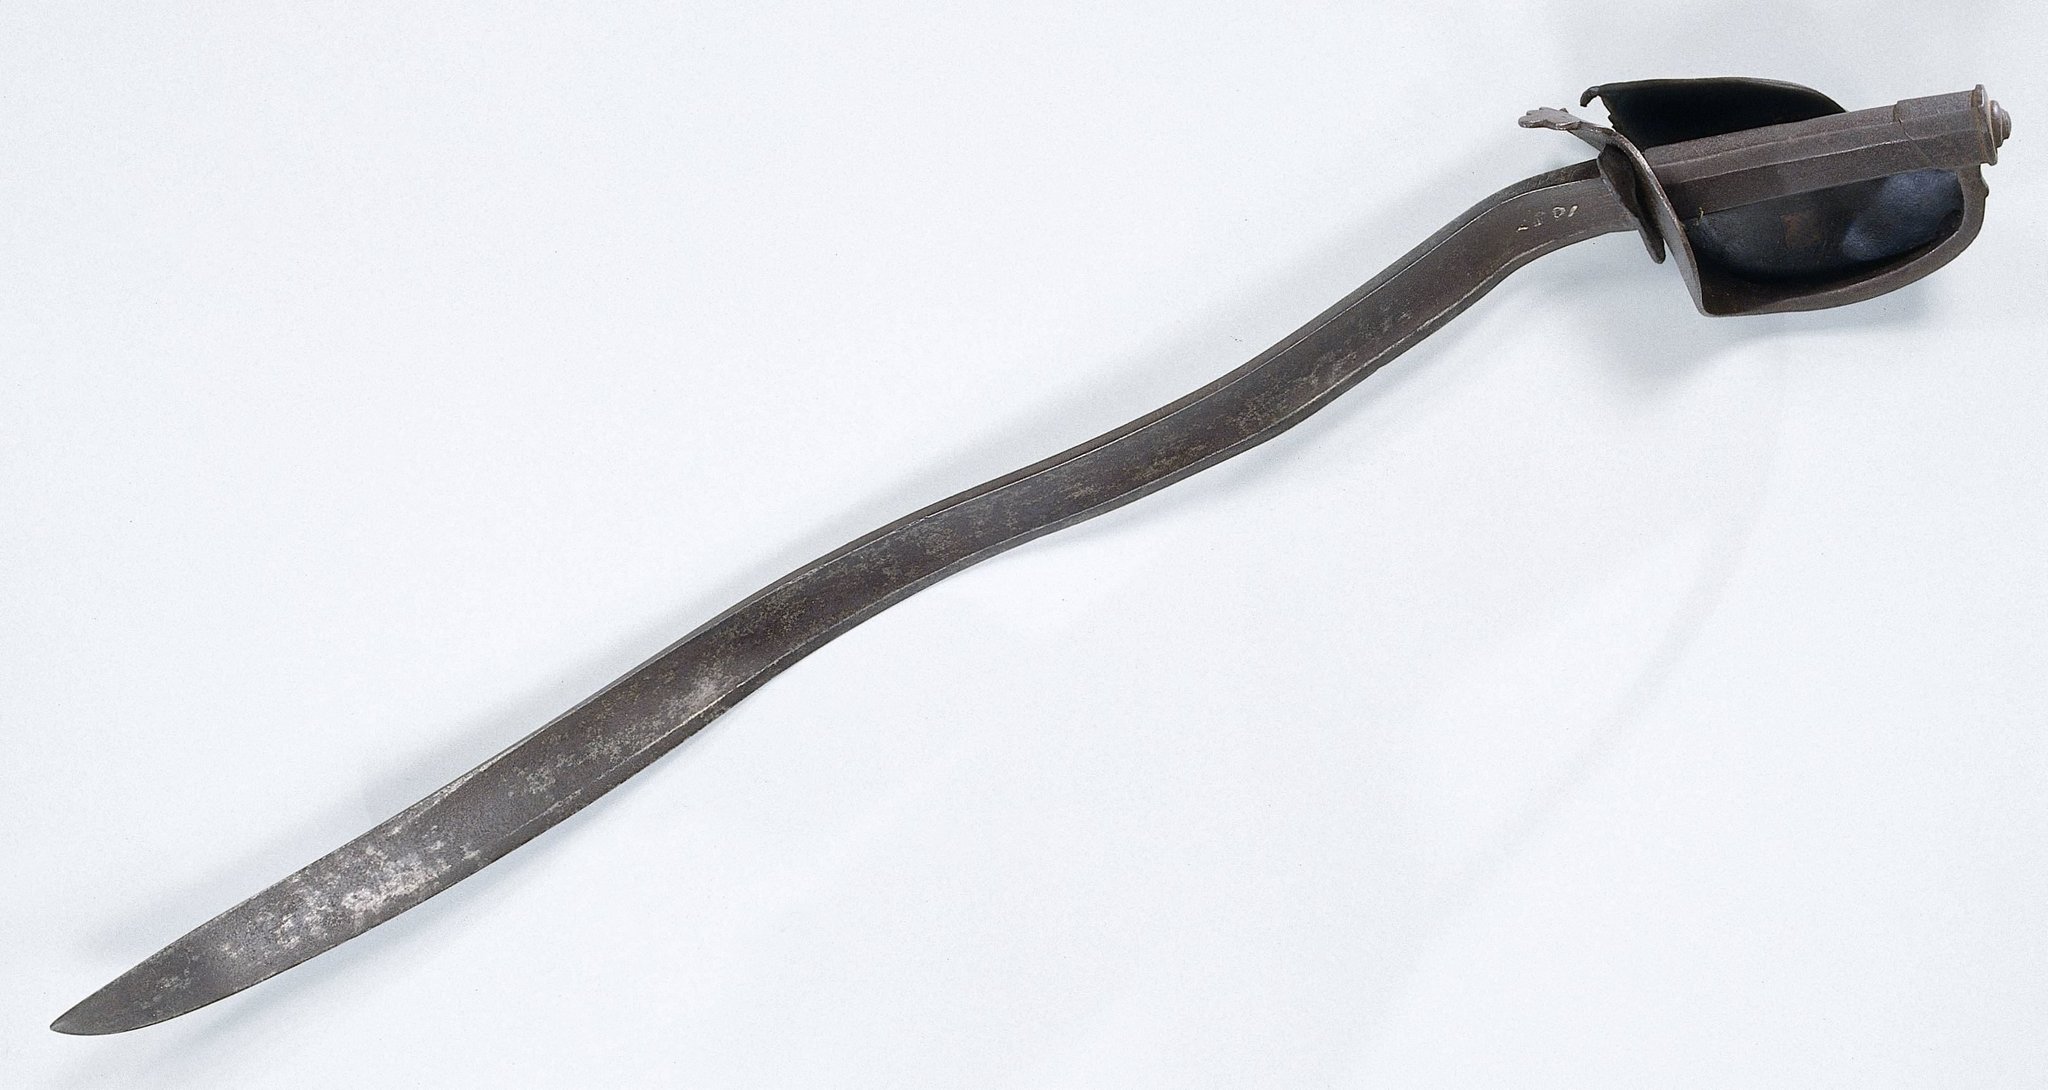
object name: sabre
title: Marinesabel afkomstig van de Kanonneerboot Nr. 2 van J. C. J. van Speyk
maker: Anonymous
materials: iron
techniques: forging, striking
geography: netherlands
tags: jan van speyk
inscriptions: inscription: ‘B’, inscription, inscription: ‘3’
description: On 5 October 1833 the amount raised by the lottery was announced. After costs the lottery made ? 6484,98. A total of 5723 tickets had been sold and 911 prizes awarded.